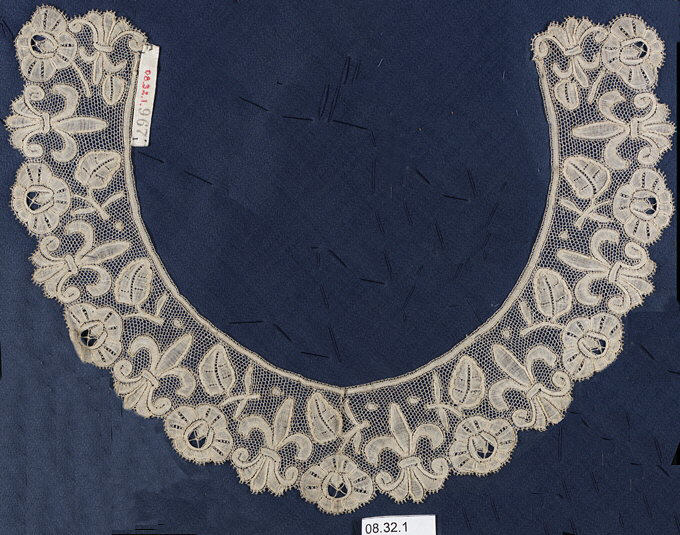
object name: collar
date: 1801-1900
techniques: lace